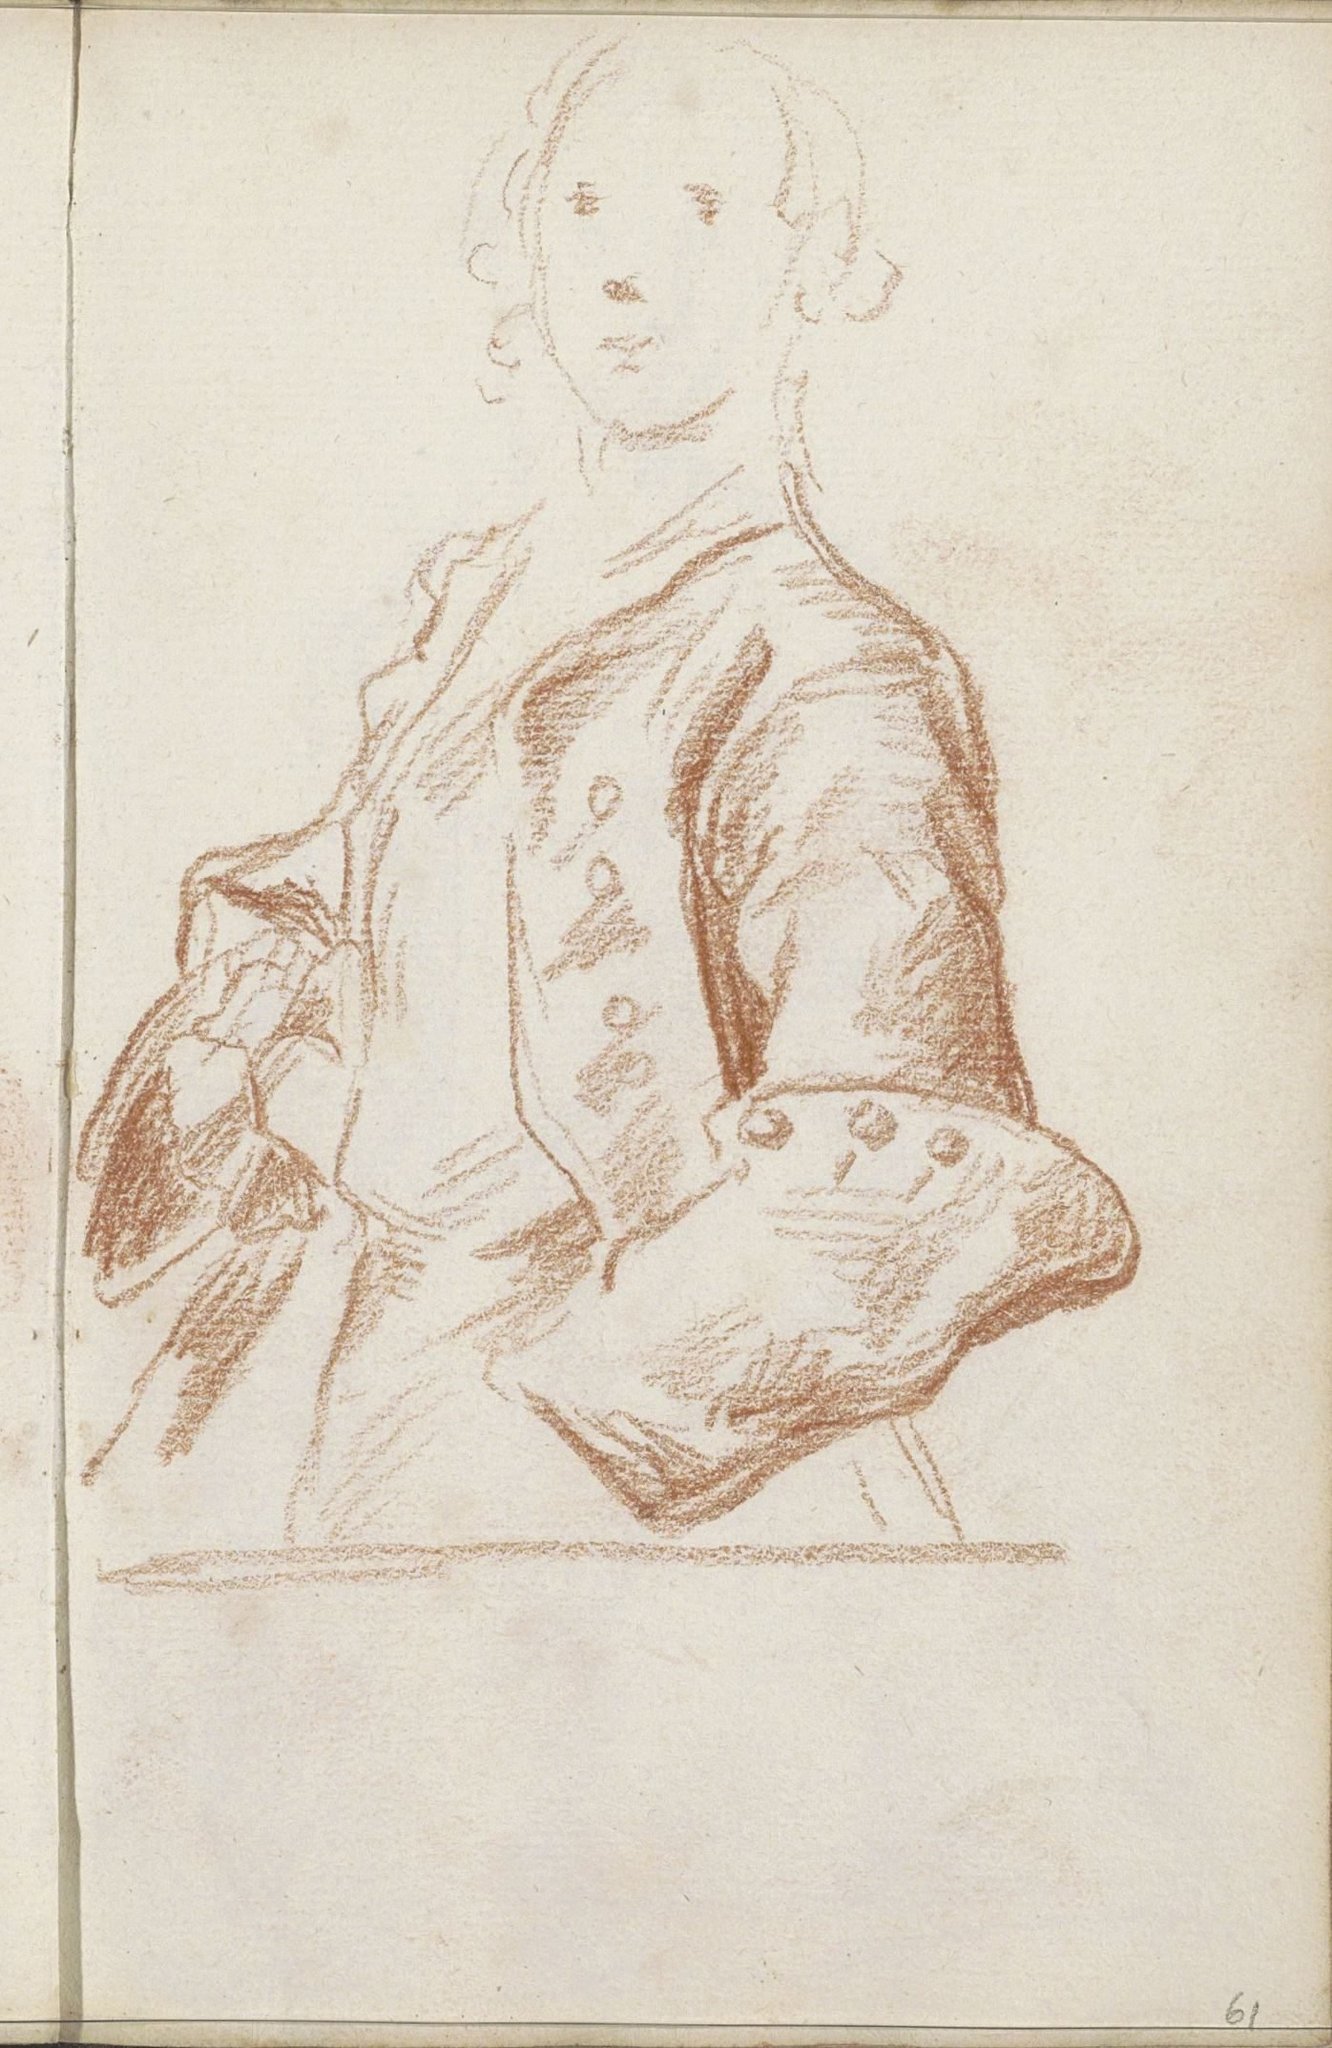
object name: sketchbook leaf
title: Staande man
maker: petrus johannes van reysschoot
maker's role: draughtsman, print maker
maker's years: 1702-1772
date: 1710-1772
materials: chalk, paper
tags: standing figure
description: Blad 61 recto uit een schetsboek met 105 bladen.